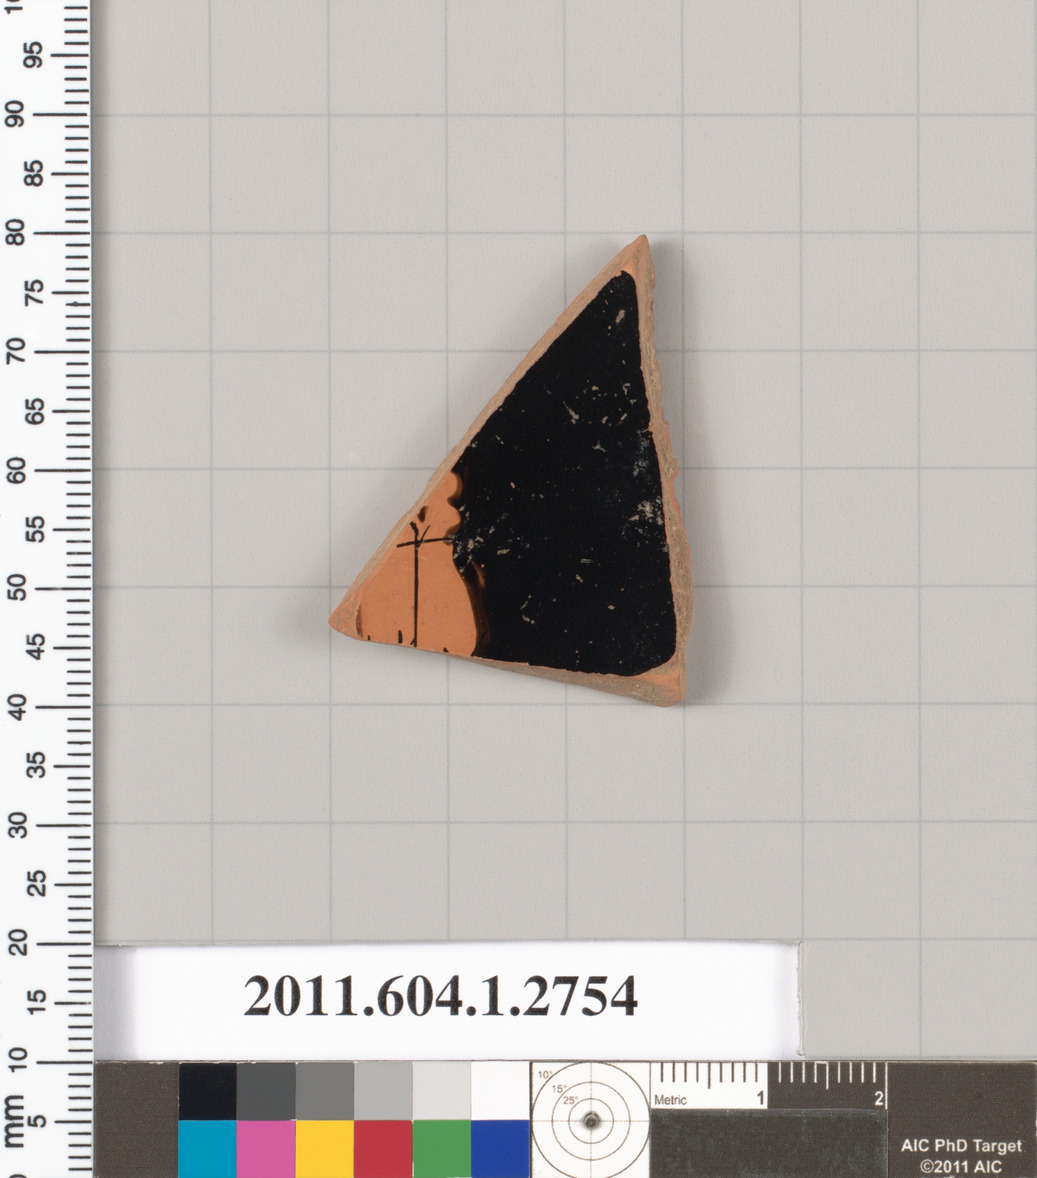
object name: kylix fragment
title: Terracotta fragment of a kylix (drinking cup)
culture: greek, attic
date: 475-451 BCE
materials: terracotta